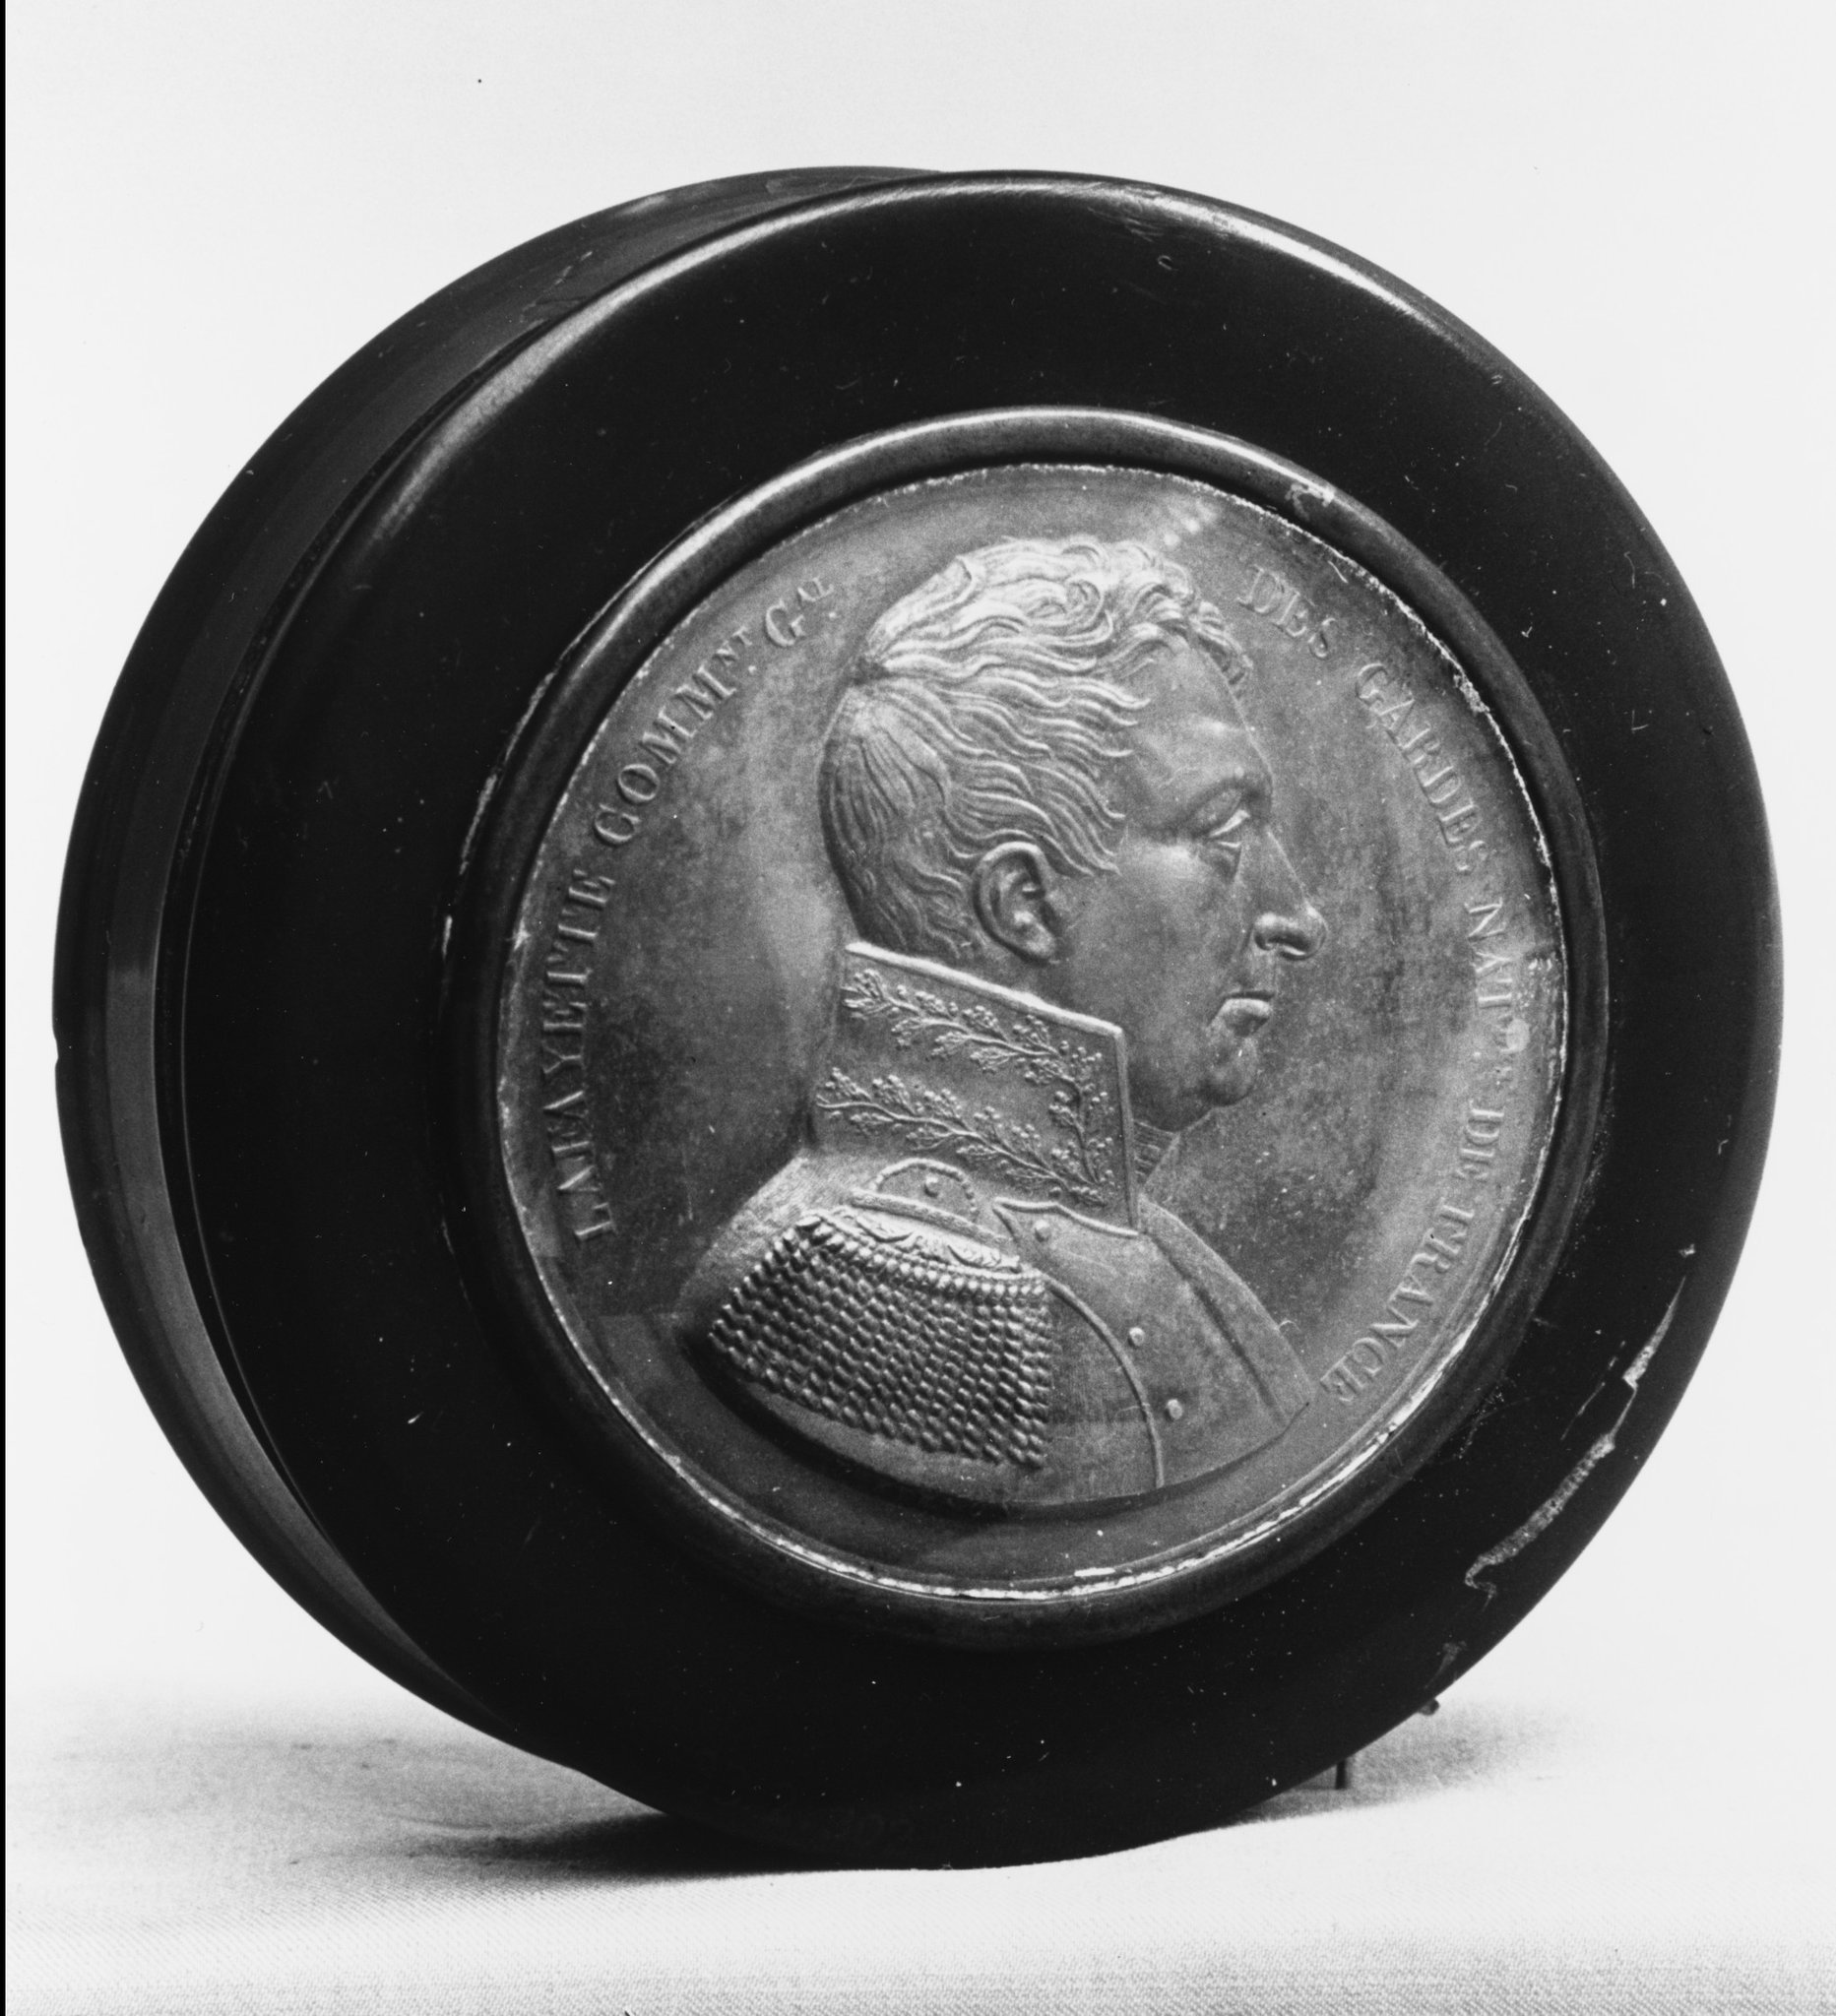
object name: medallion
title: Medallion of the Marquis de Lafayette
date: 1800-1883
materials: brass, gilt, shell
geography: france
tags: men,profiles,marquis de lafayette